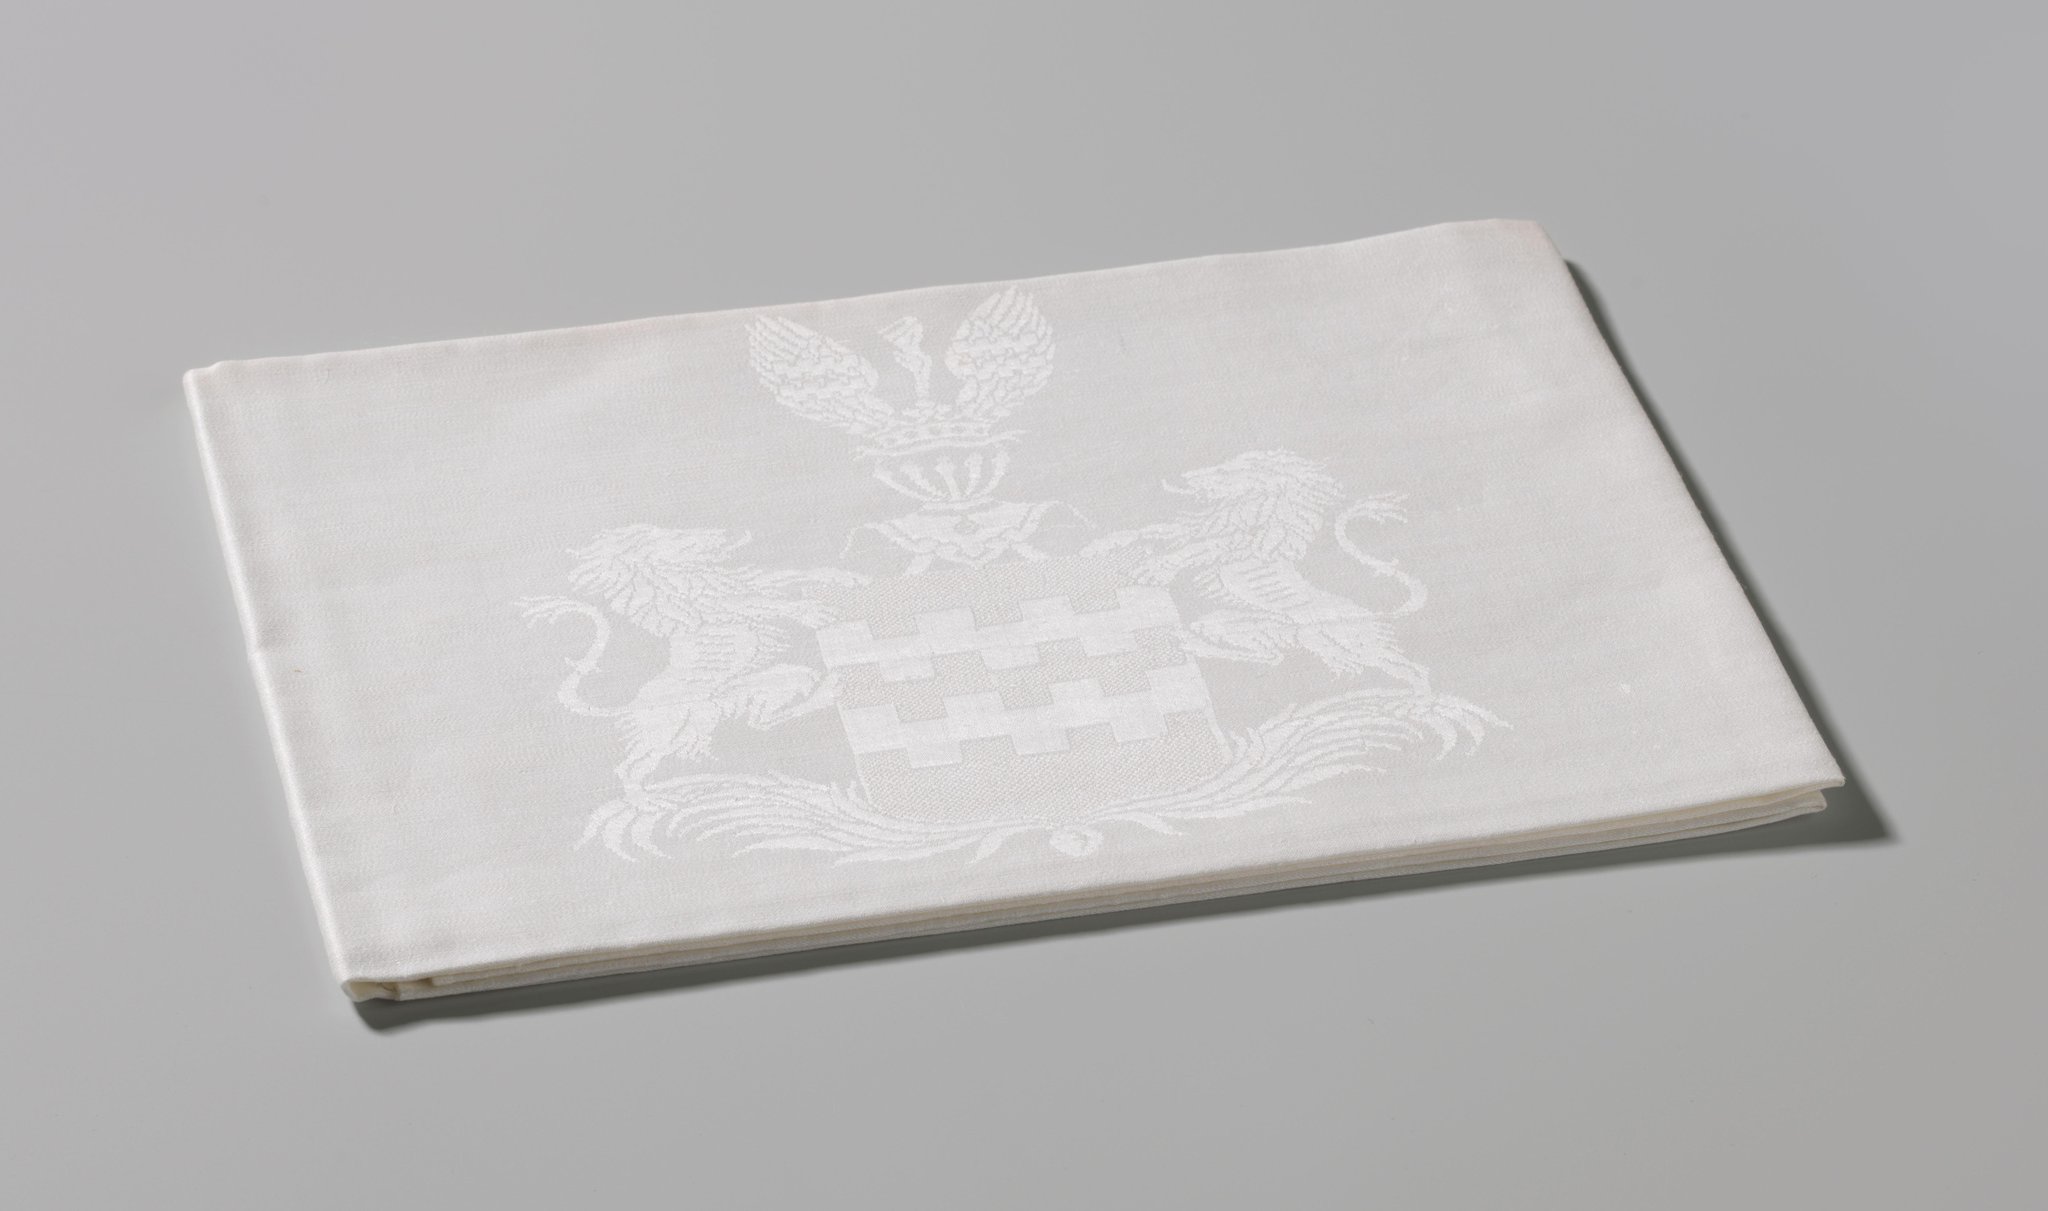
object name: napkin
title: Servet van wit linnendamast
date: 1874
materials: linen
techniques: damask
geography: north brabant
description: Wit linnen damasten servet met voluten en het wapen Van Boelens van der Haer.